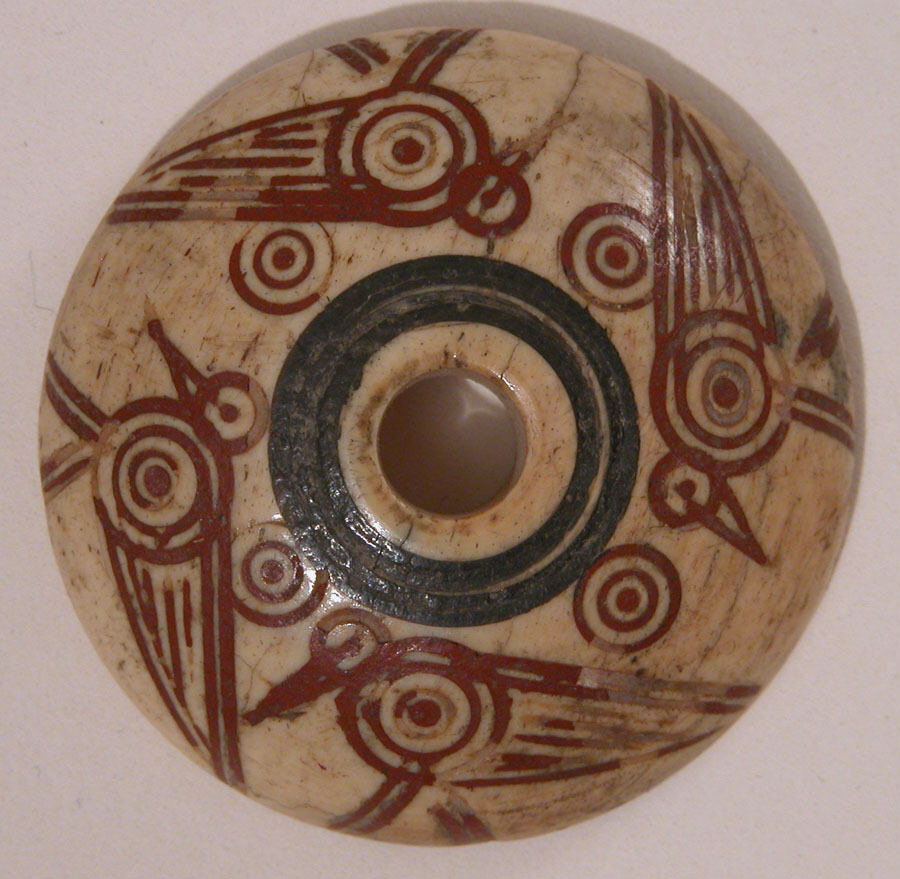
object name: spindle whorl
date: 701-1000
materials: bone, paint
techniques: incising, inlay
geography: egypt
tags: birds